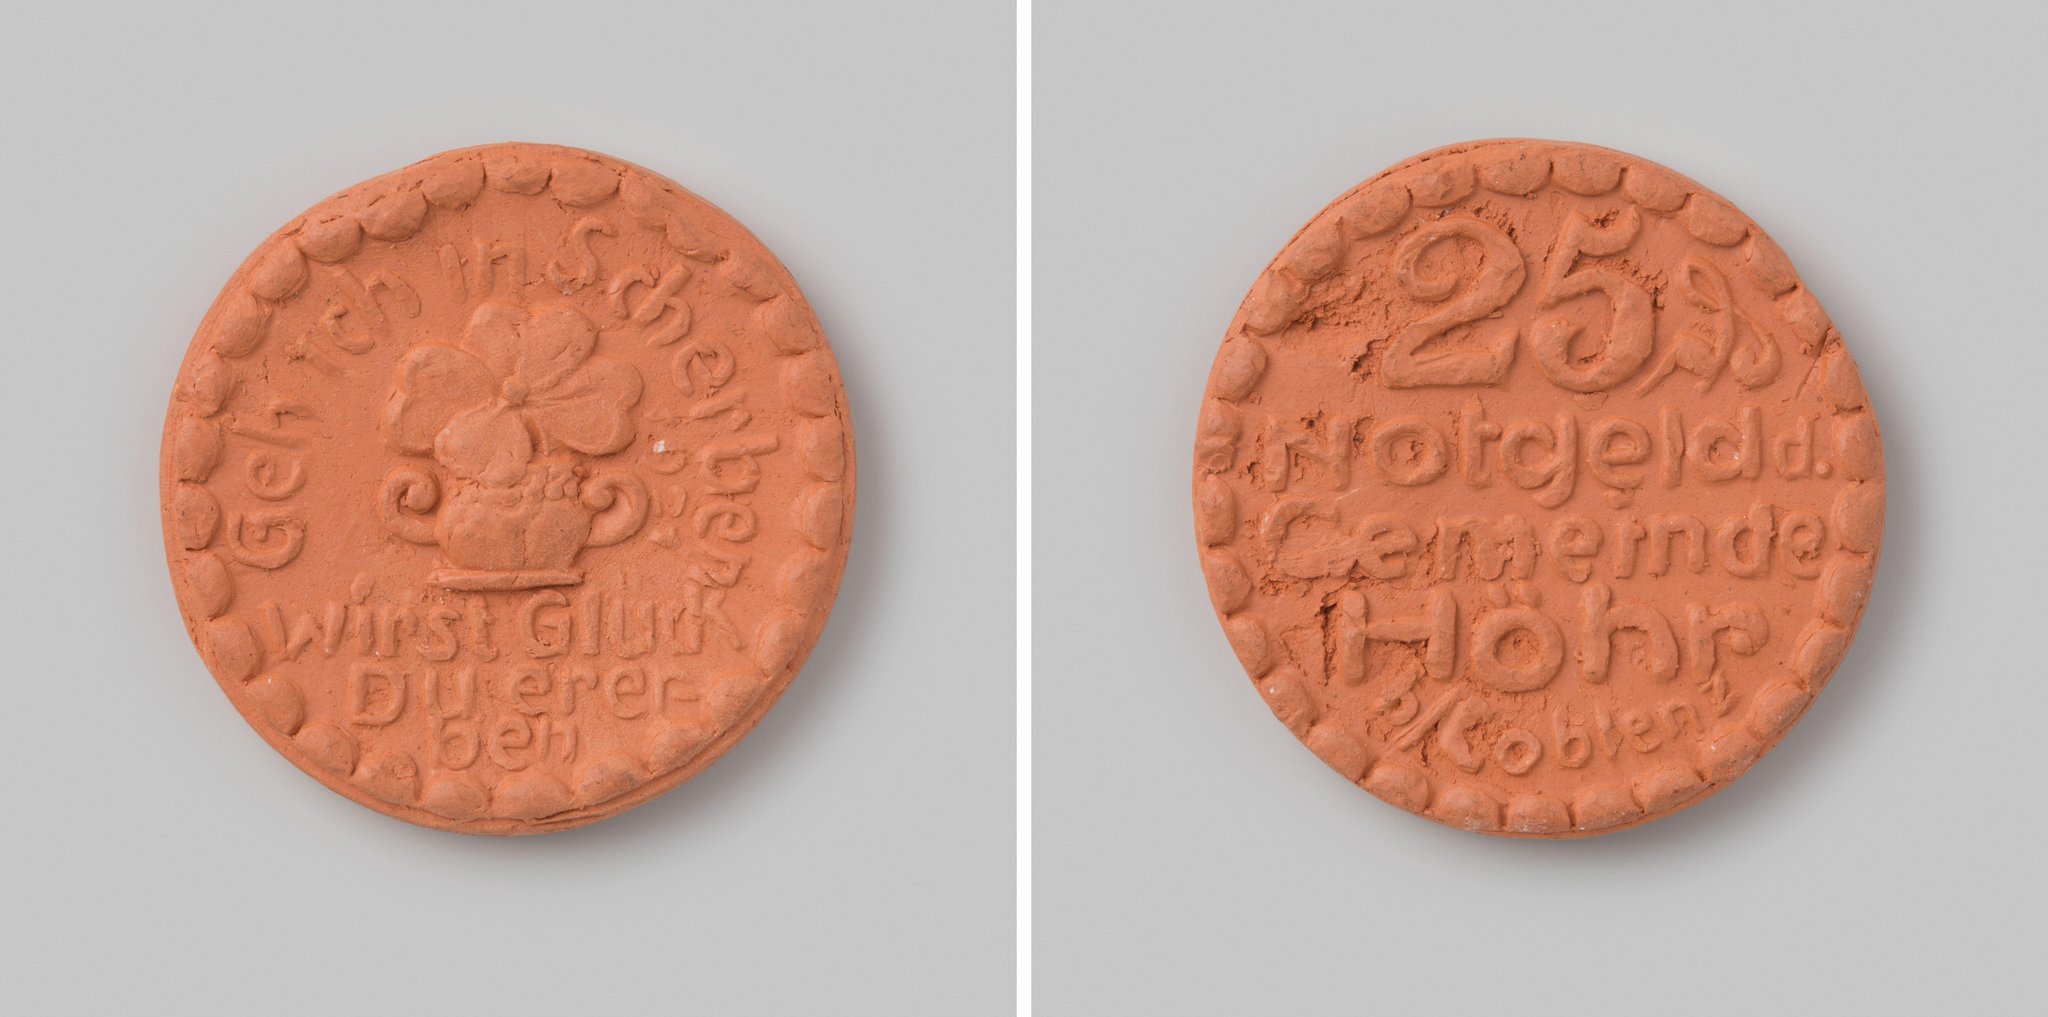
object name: coin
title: 25 mark notgeld uit Duitsland, Höhr, Coblenz,1921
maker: a. kamp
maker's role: sculptor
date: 1921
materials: porcelain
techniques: casting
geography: höhr-grenzhausen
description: Porseleinen rood gekleurde pseudomunt. Voorzijde: vaas met bloemen. Keerzijde: waarde-aanduiding in twee regels, waaronder plaats-aanduiding in drie regels. Gladde rand.